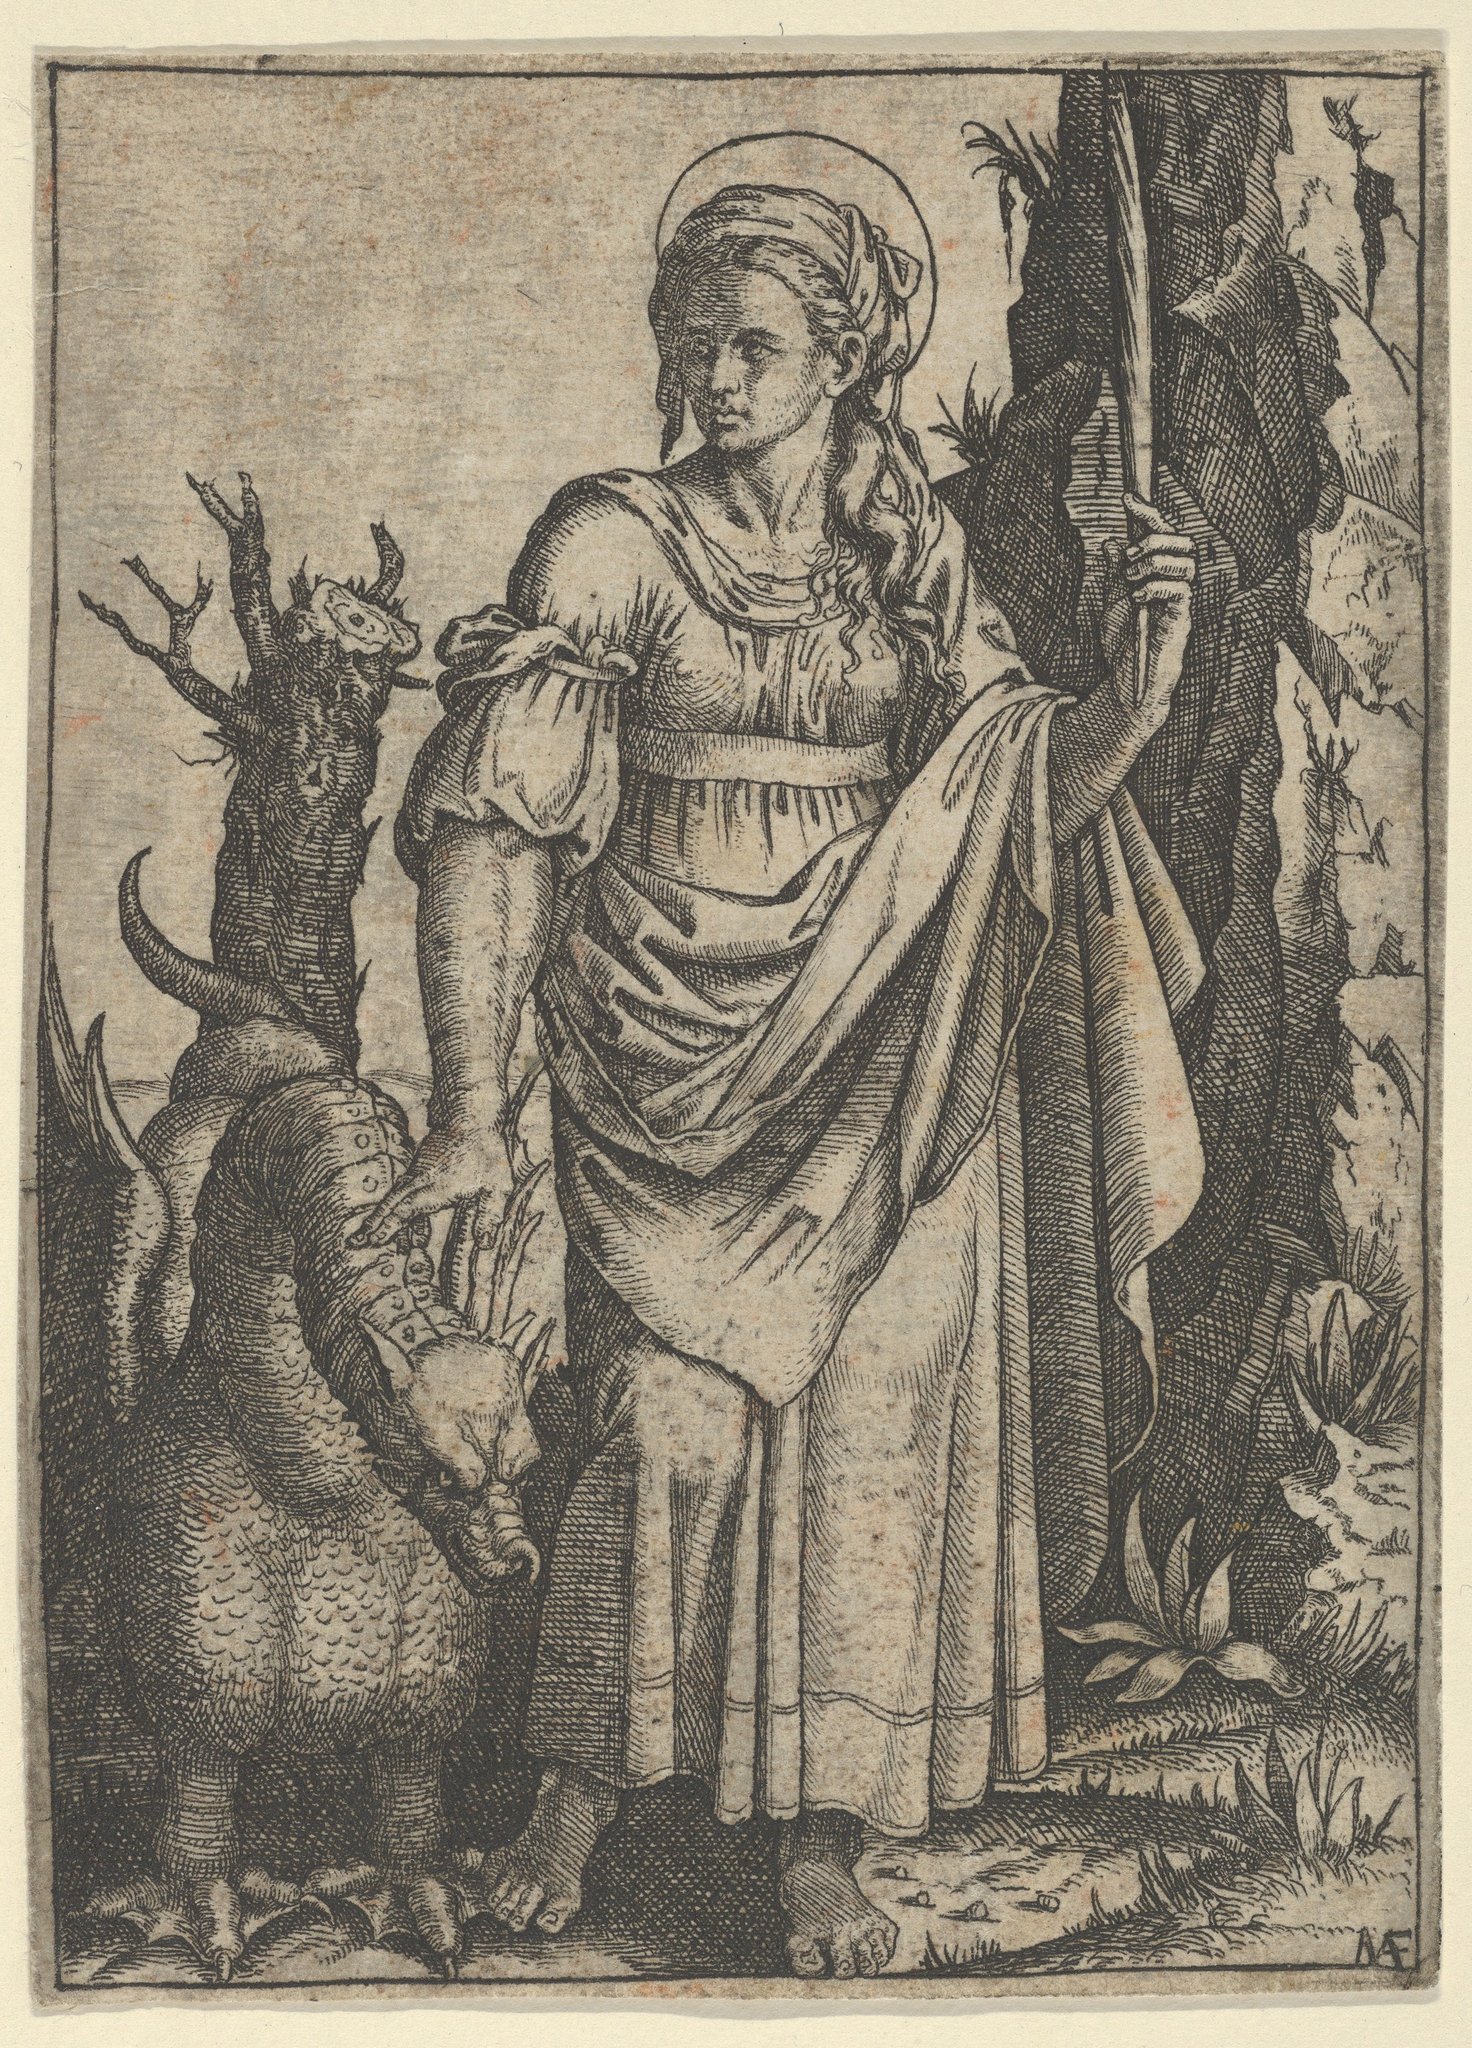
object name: print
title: St Margaret holding a palm in her raised left hand, a dragon at her right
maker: marcantonio raimondi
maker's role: artist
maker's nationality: italian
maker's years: 1475-1534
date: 1500-1510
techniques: engraving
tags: women,dragons,palms,saints